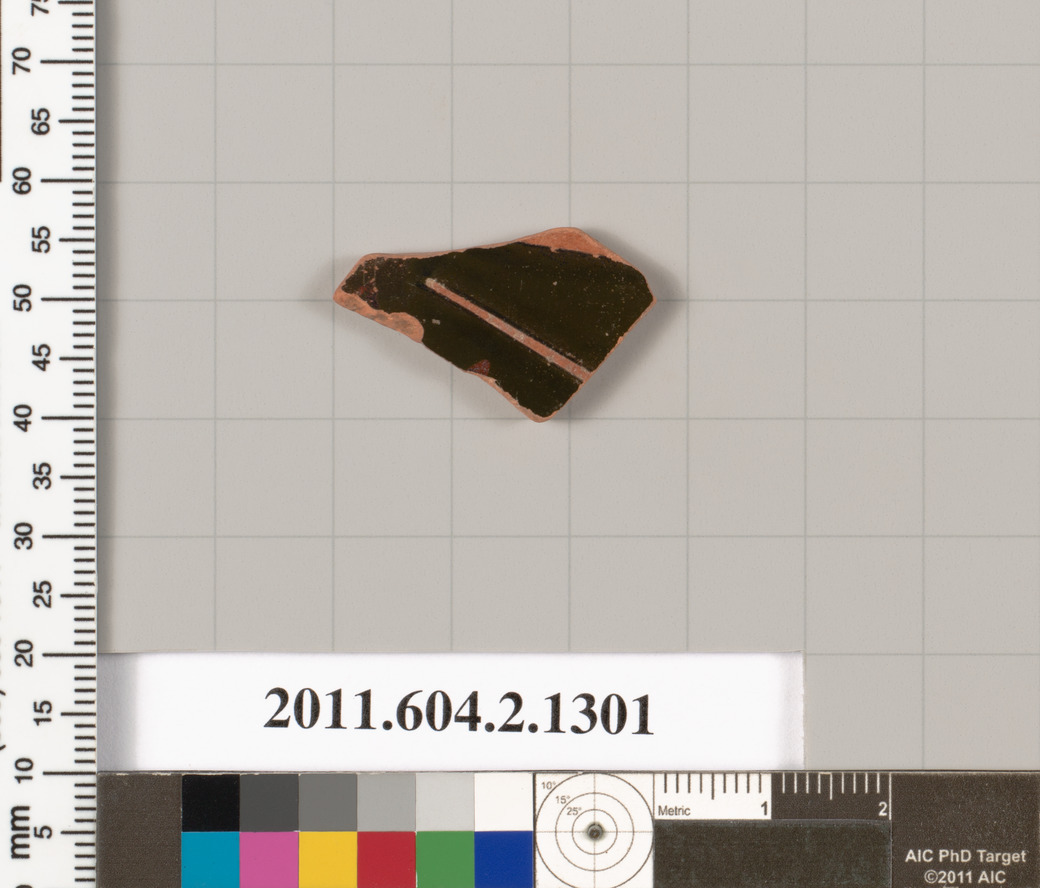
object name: skyphos fragment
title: Terracotta fragment of a skyphos (deep drinking cup)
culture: greek, attic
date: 475-451 BCE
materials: terracotta